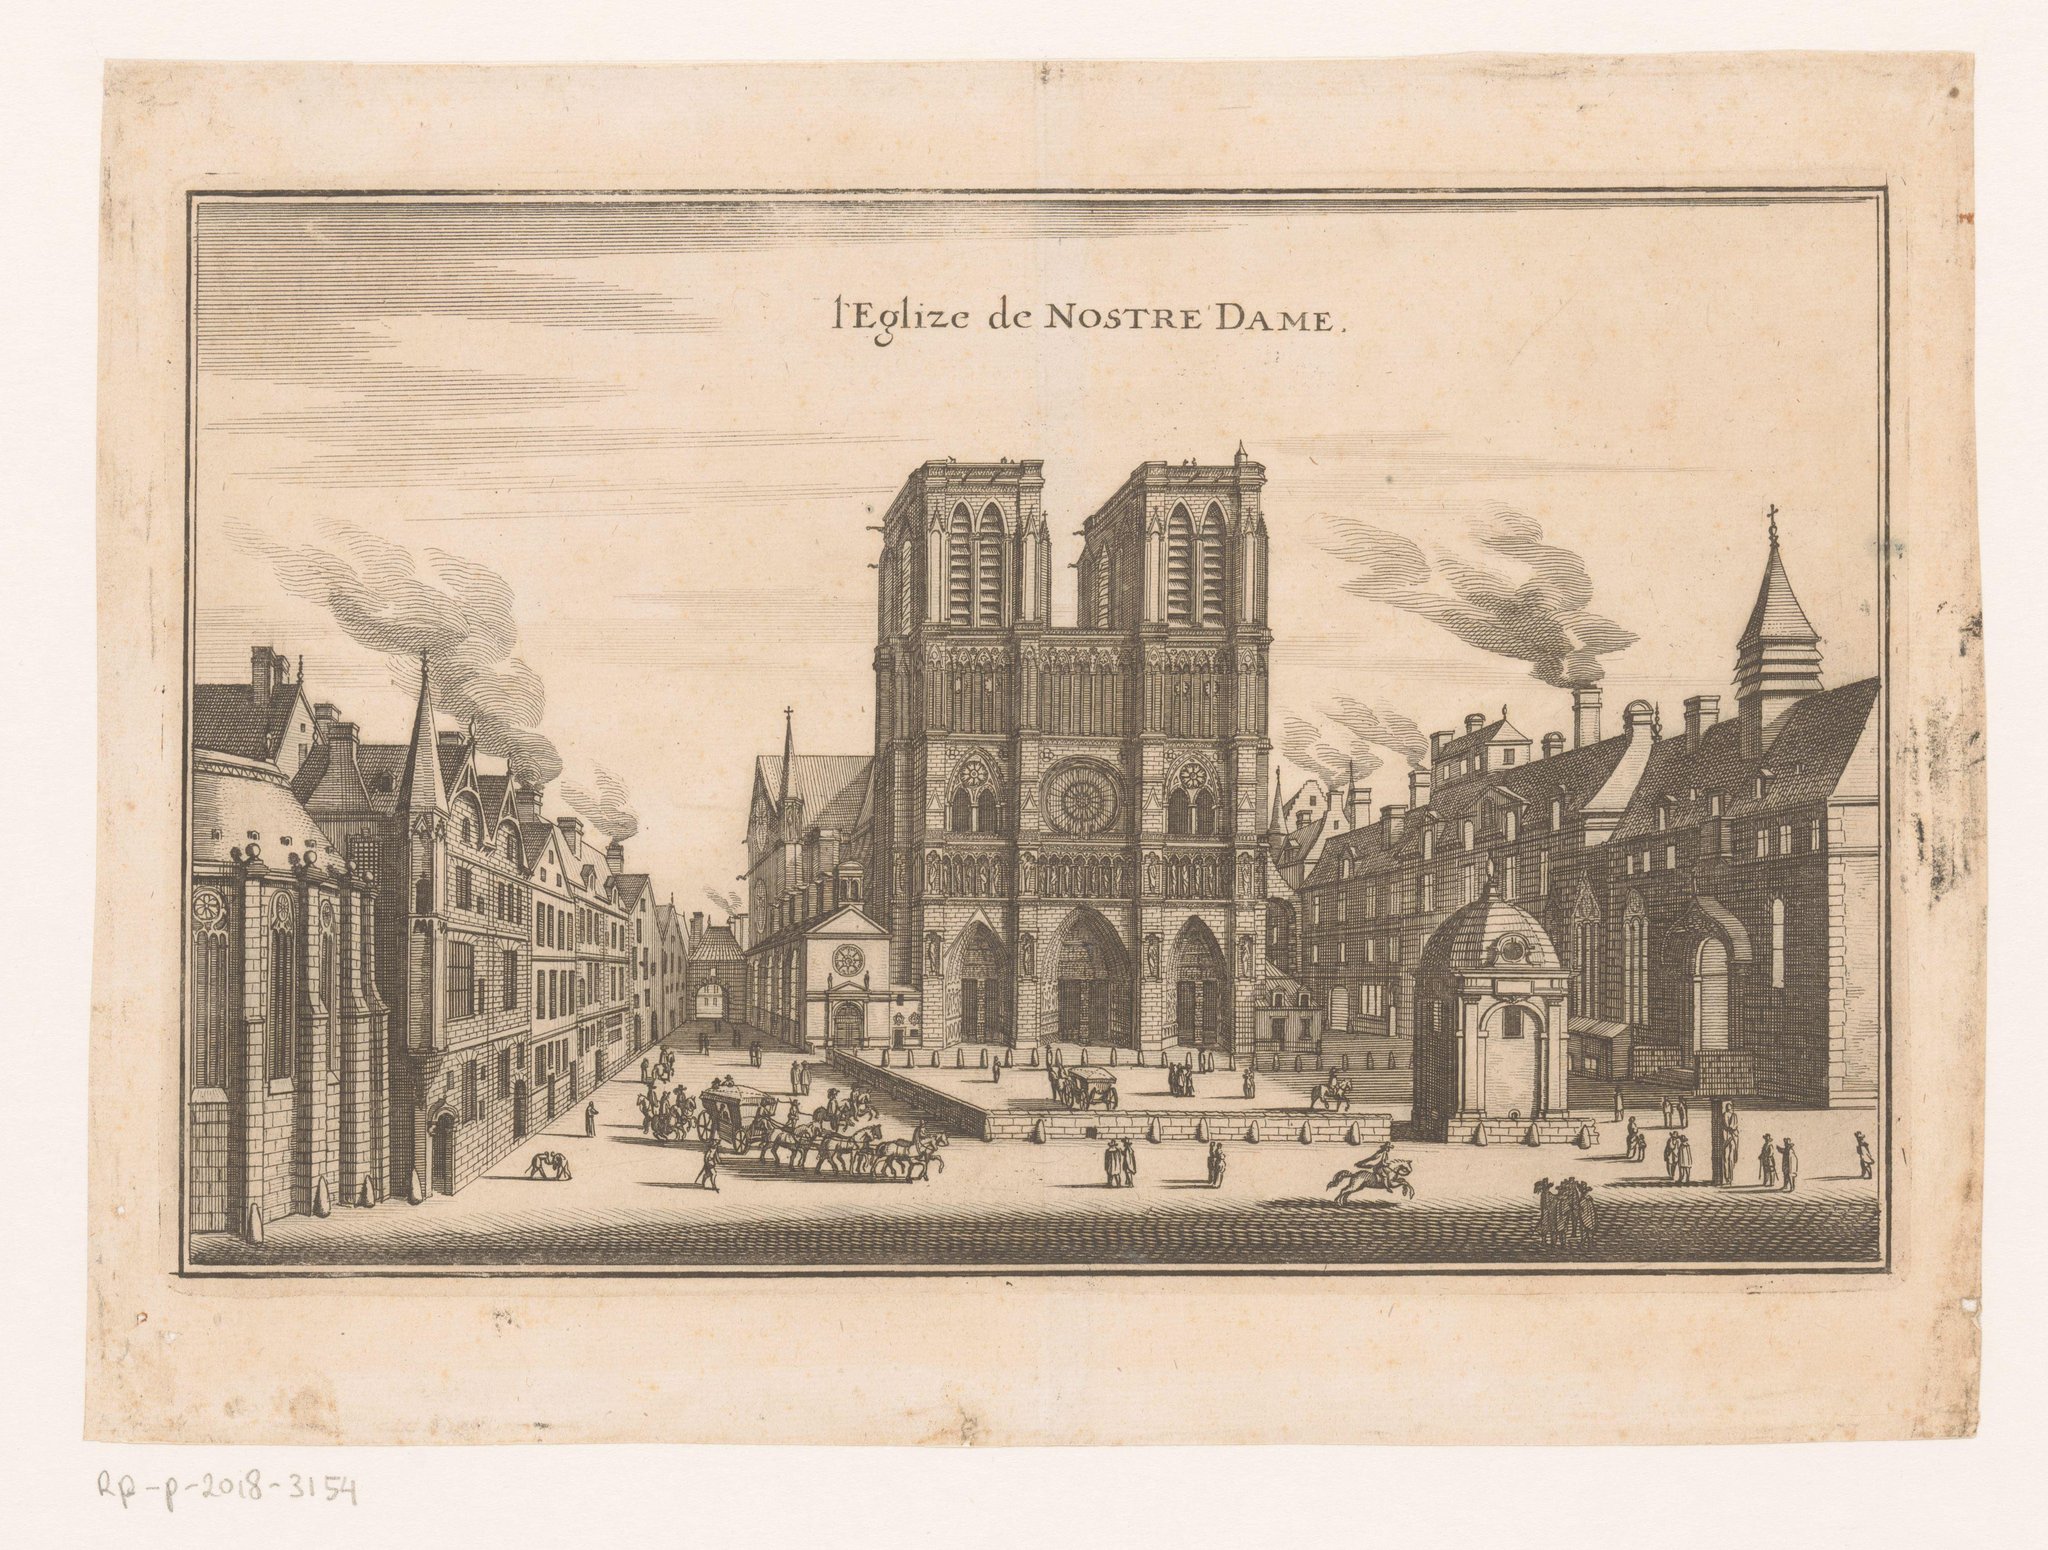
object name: print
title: Gezicht op de Notre-Dame te Parijs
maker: Anonymous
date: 1650-1700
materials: paper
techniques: etching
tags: church (exterior), roman catholic church, paris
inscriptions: collector's mark: Lugt 2228